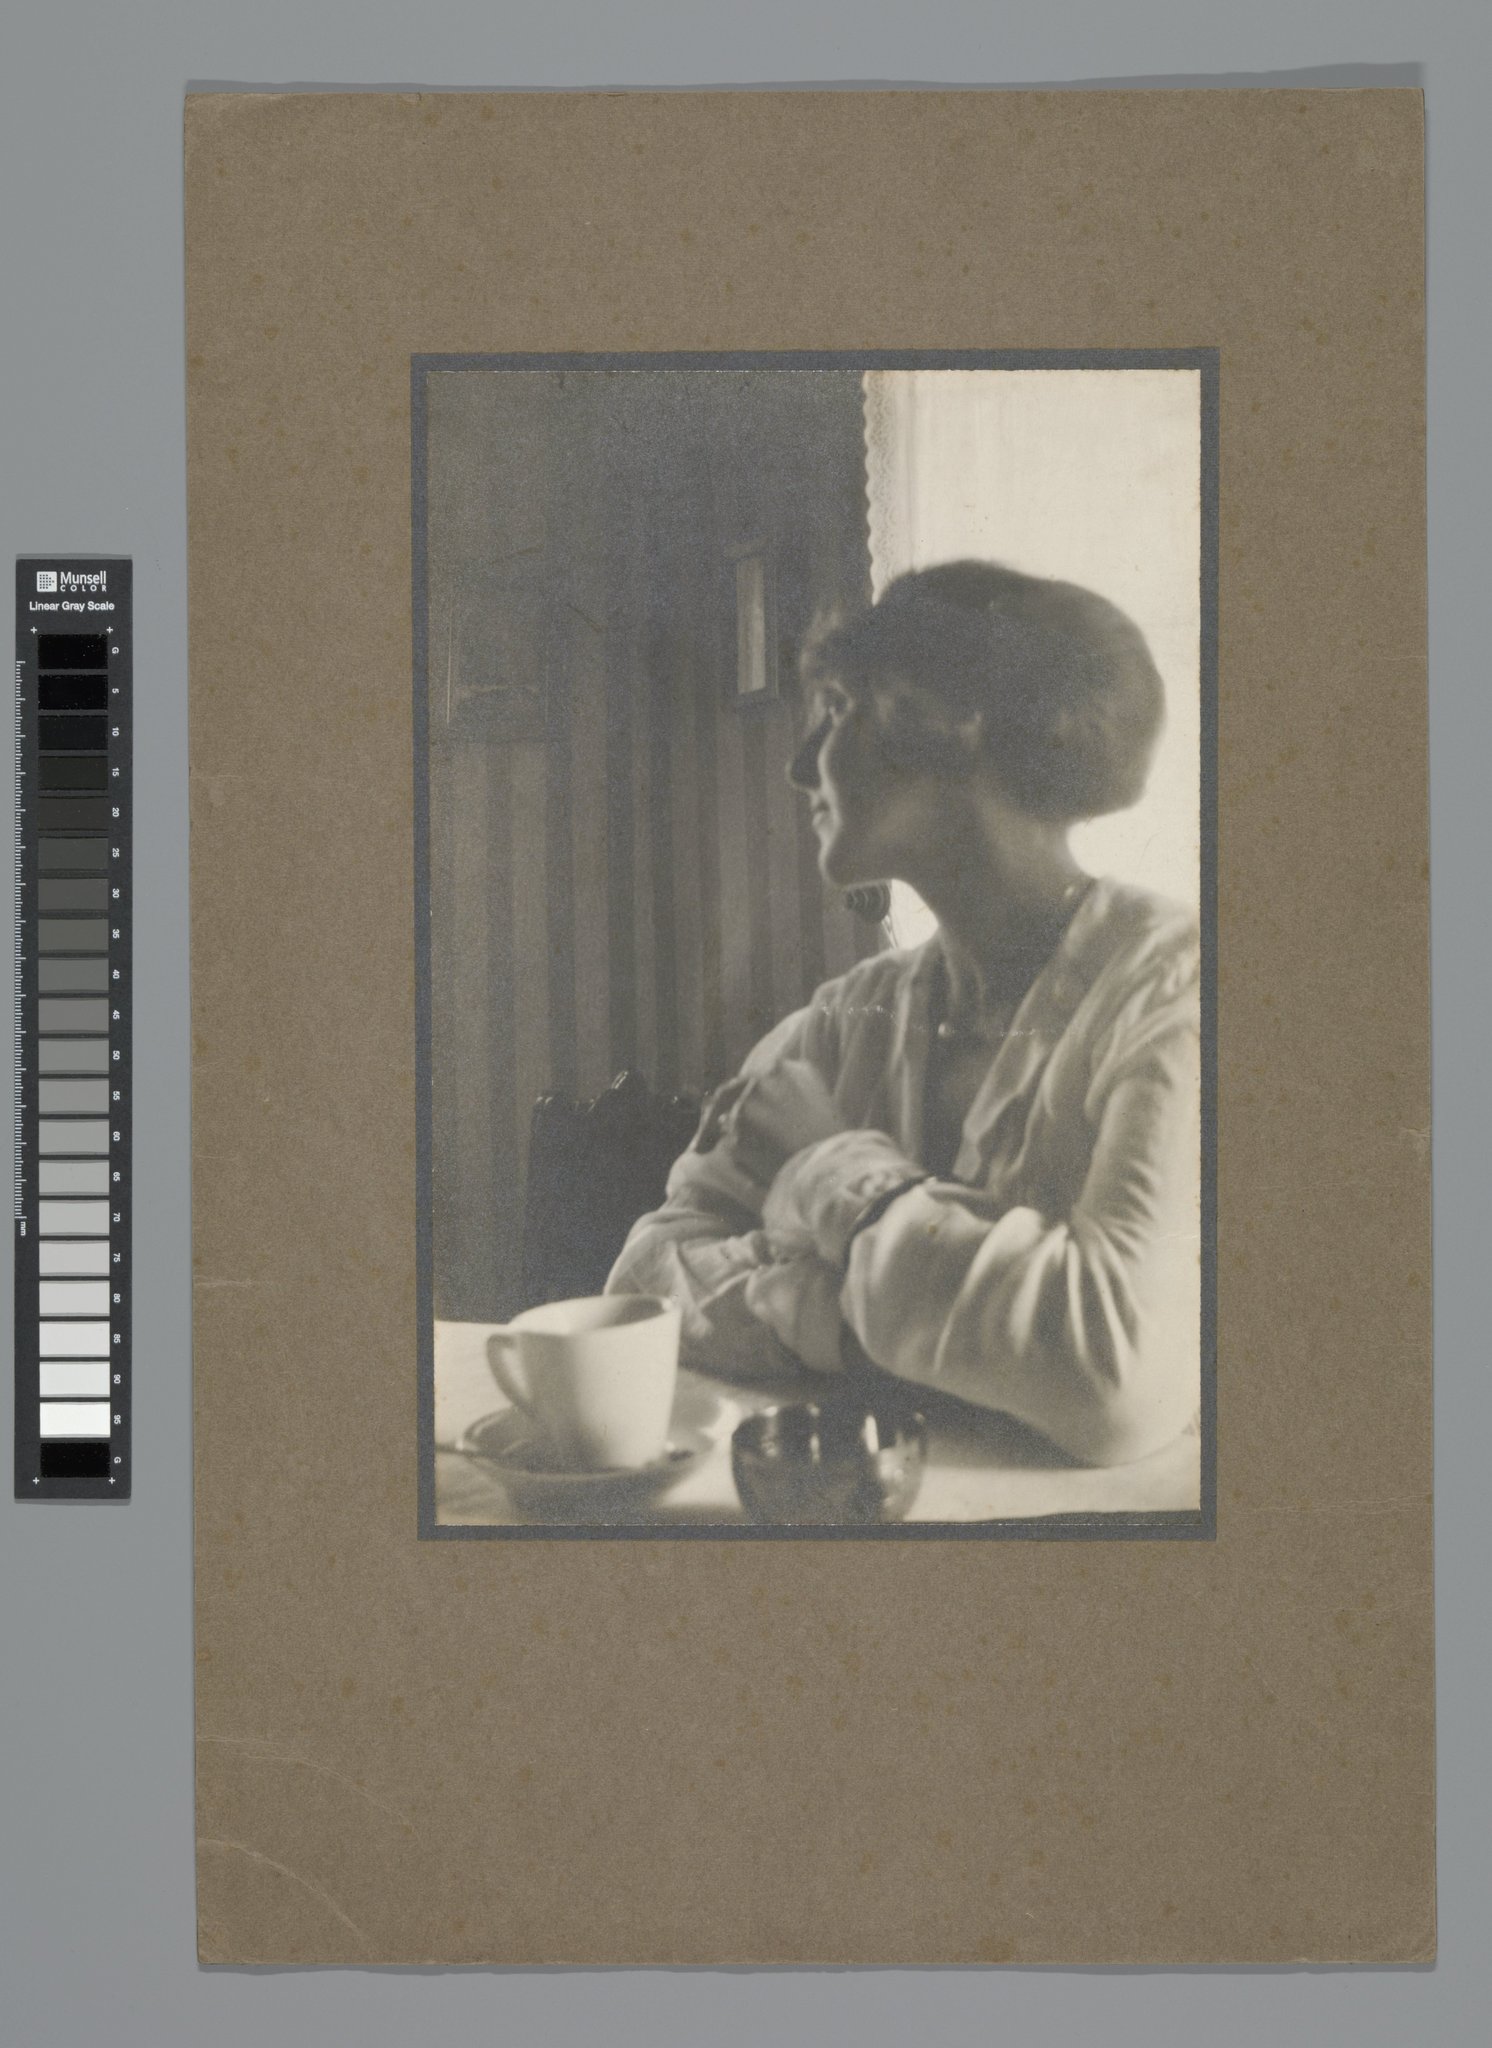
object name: photograph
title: Sofie de Vries-Dalberg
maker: willem witsen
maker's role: draughtsman, painter, print maker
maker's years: 1860-1923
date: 1860-1915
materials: cardboard, paper, photographic support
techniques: gelatin silver print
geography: amsterdam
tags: niedermarsberg, sophie de vries-dalberg